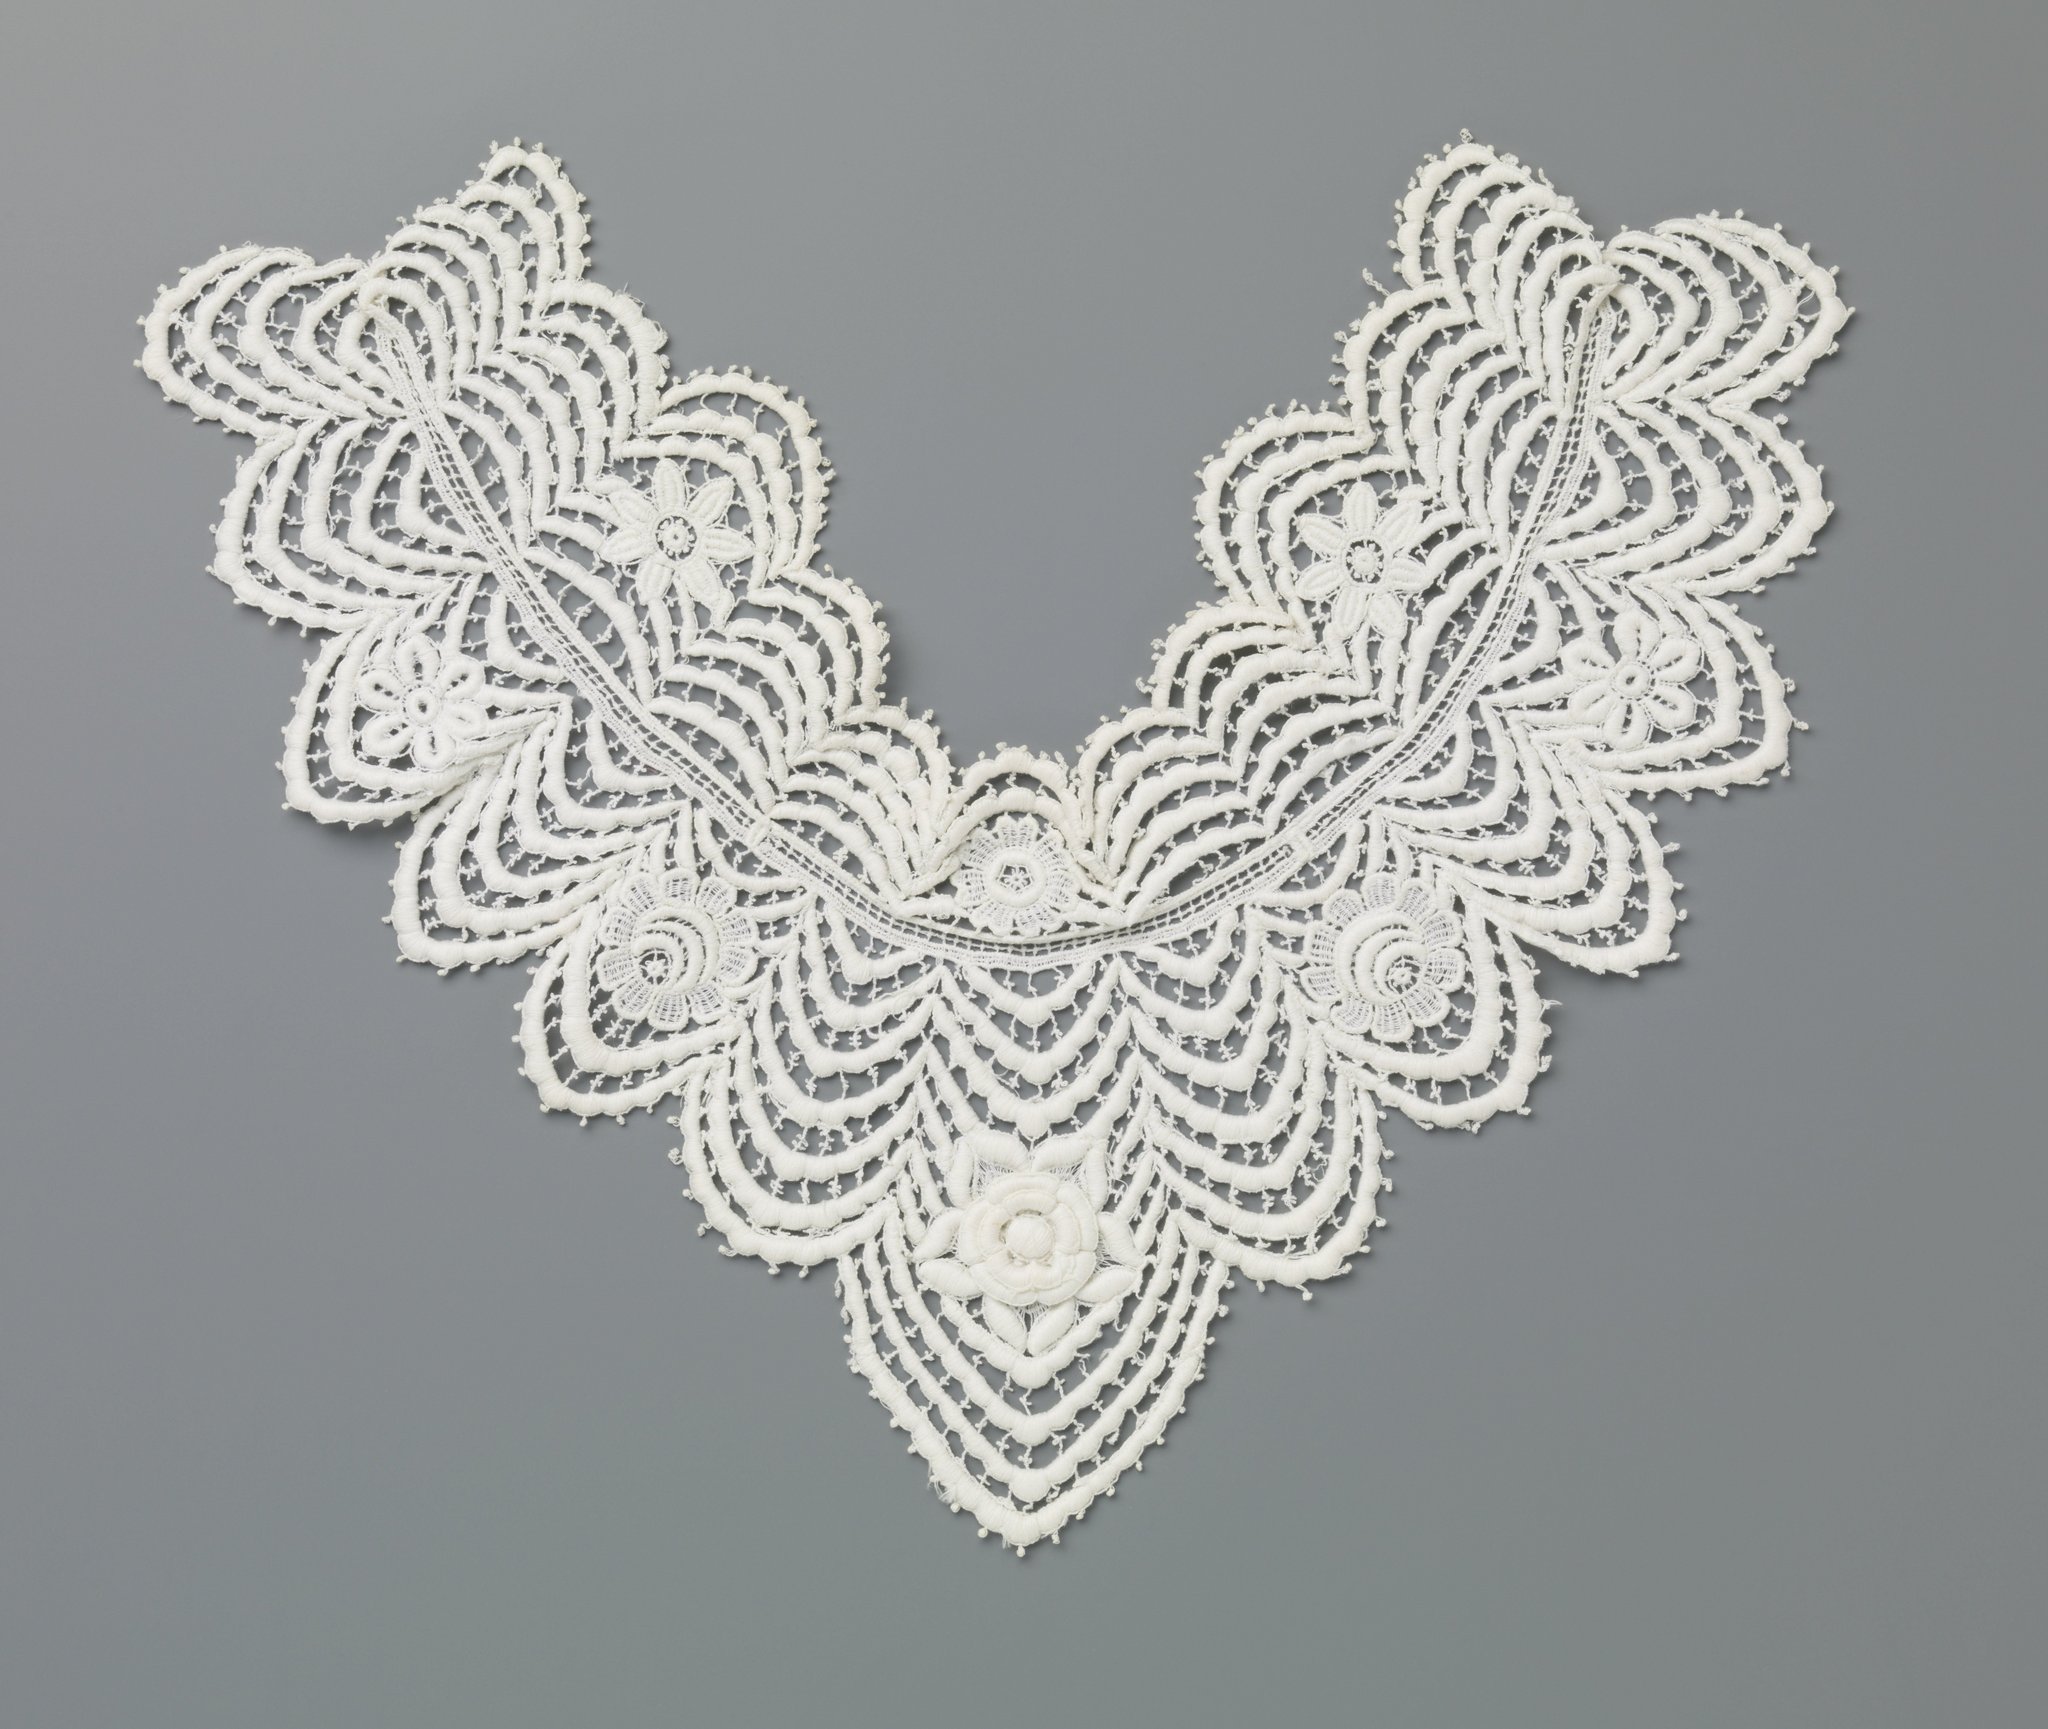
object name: womenswear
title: Kraag van machinale kant met dertien spitsovale schulpen onderaan en elf halfcirkelvormige schulpen bovenaan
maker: Anonymous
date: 1905-1910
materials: cotton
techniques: lace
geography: switzerland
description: Kraag van machinale kant: etskant, imitatie haakwerk. Halfcirkelvormig model met zowel aan onder- als bovenzijde een schulpenrand. De dertien spitsovale schulpen aan de onderzijde van de kraag nemen richting het midden in grote toe. De schulpen zijn opgebouwd uit vijf tot tien in elkaar geschoven boogjes. De boogjes zijn dik, als dikke gefestonneerde cordons, en zijn onderling met gepicoteerde spijltjes verbonden. In de middelste schulp staat een stervormige bloem met een rozetbloem als bloemhart. Links en rechts staan nog in een schulp een roos en in een andere schulp een rozetbloem met zes ovale bloemblaadjes. De elf halfcirkelvormige schulpen bovenaan de kraag zijn op dezelfde manier opgebouwd, maar zijn ronder dan de onderste schulpen. Bij deze schulpenrand is de middelste schulp het kleinst en hierin staat een roos. In de twee-na-laatste en tevens grootste schulp in deze rand, staat links en rechts een bloem met zeven spitsovale blaadjes.